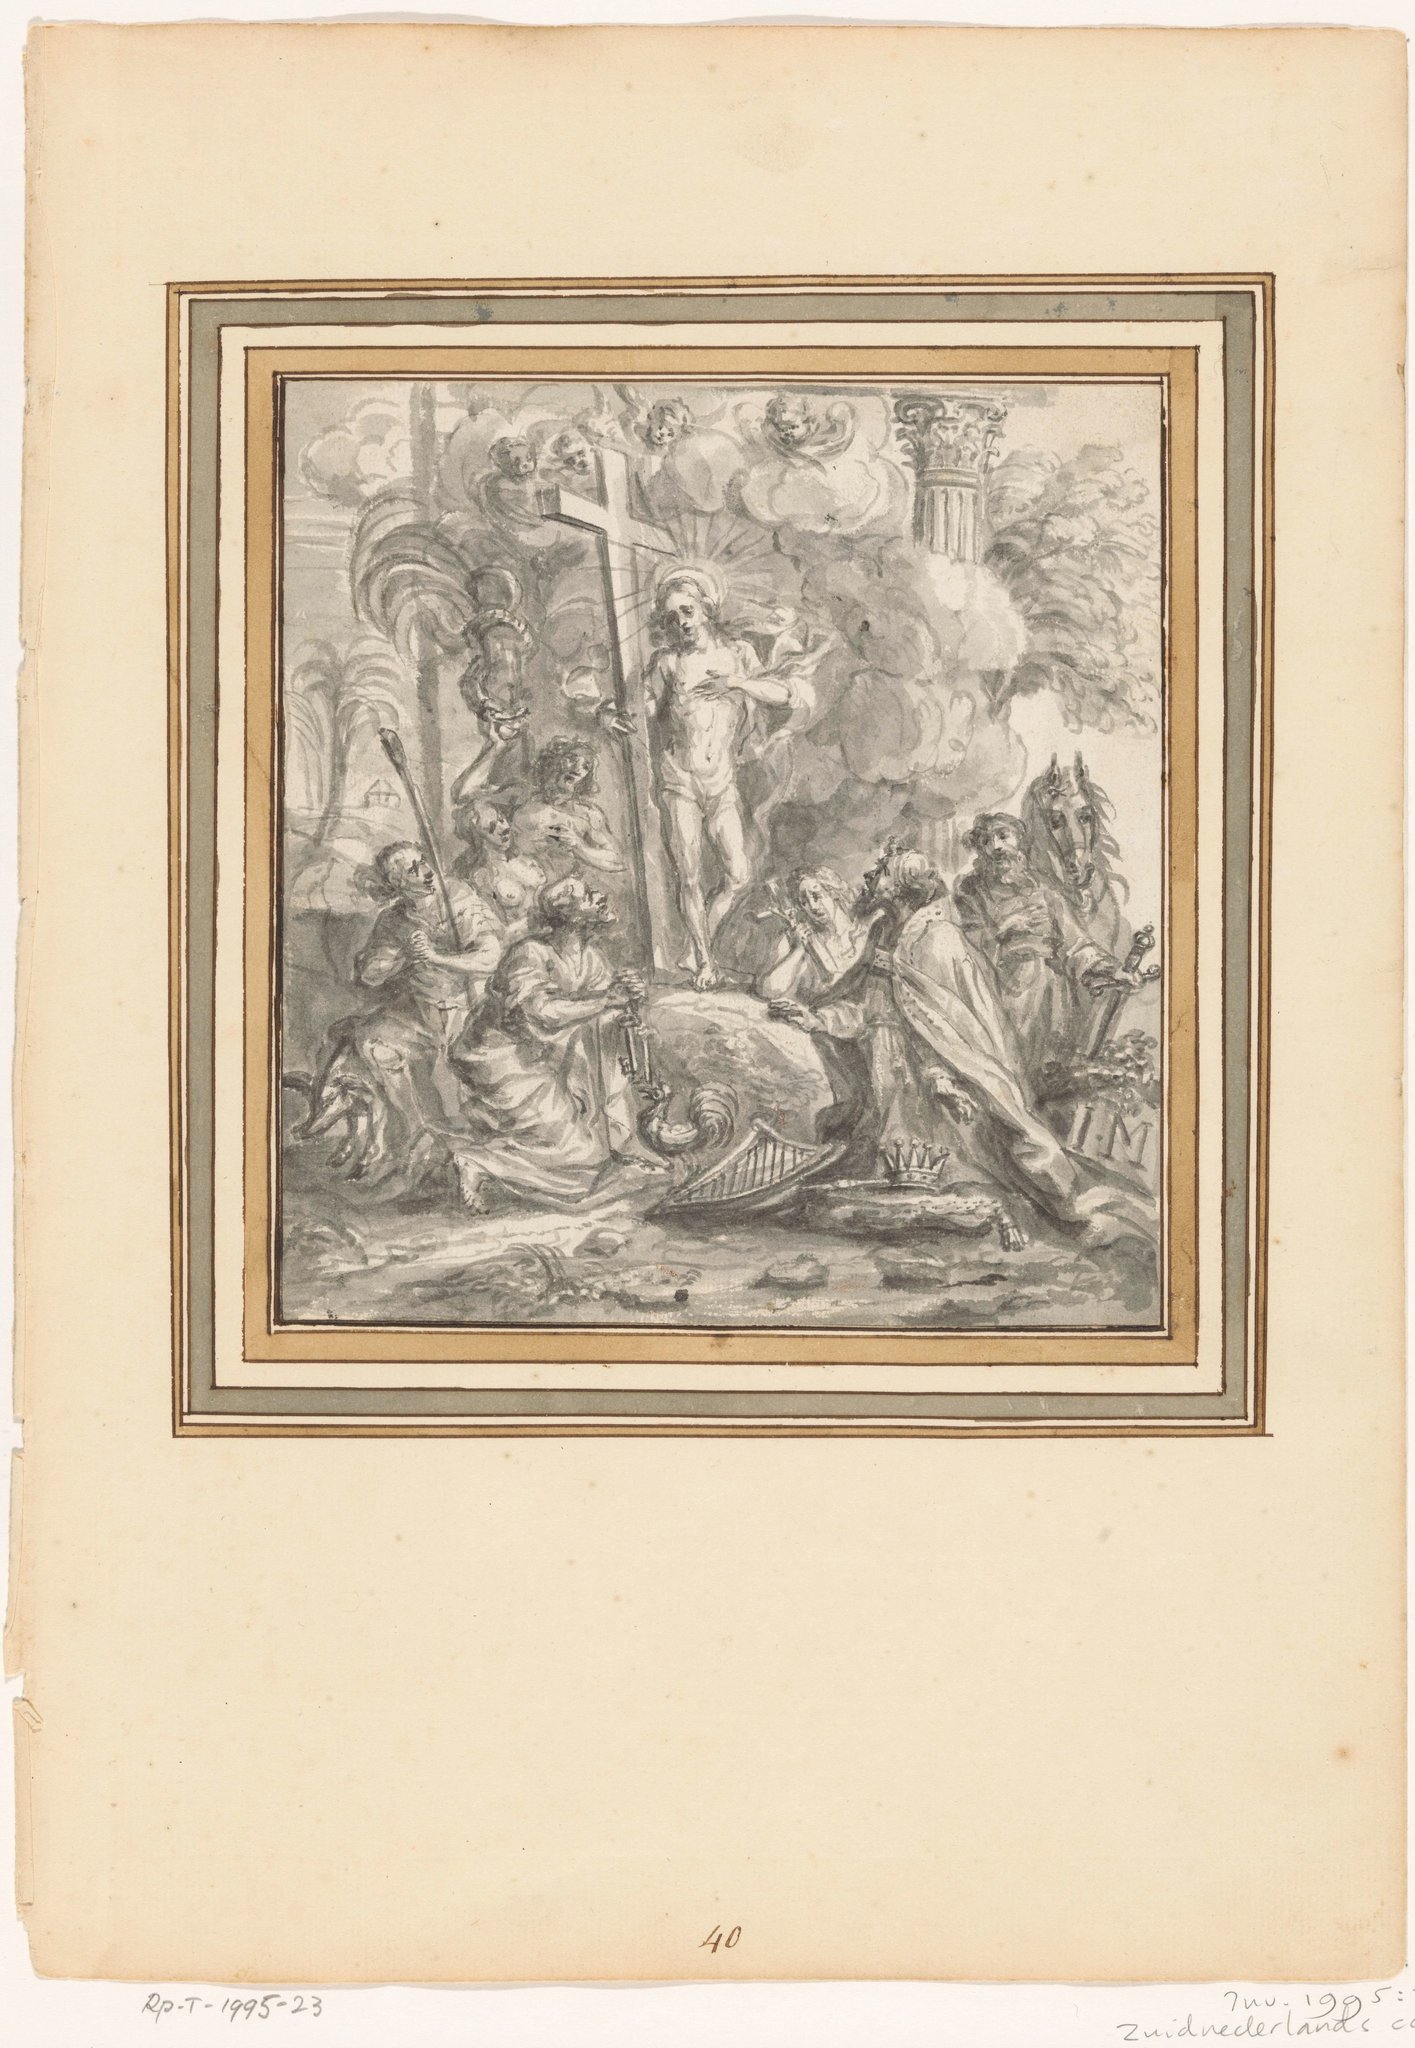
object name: drawing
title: Christus in het voorgeborchte met Adam en Eva, de Verloren Zoon, Petrus, Koning David, Maria Magdalena en Paulus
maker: Anonymous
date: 1700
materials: paper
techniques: brush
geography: southern netherlands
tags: christ in the underworld, harrowing of hell, christ in limbo, 'descensus ad inferos', 'anastasis', story of david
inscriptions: inscription: ‘.’, monogram: ‘I.M.’